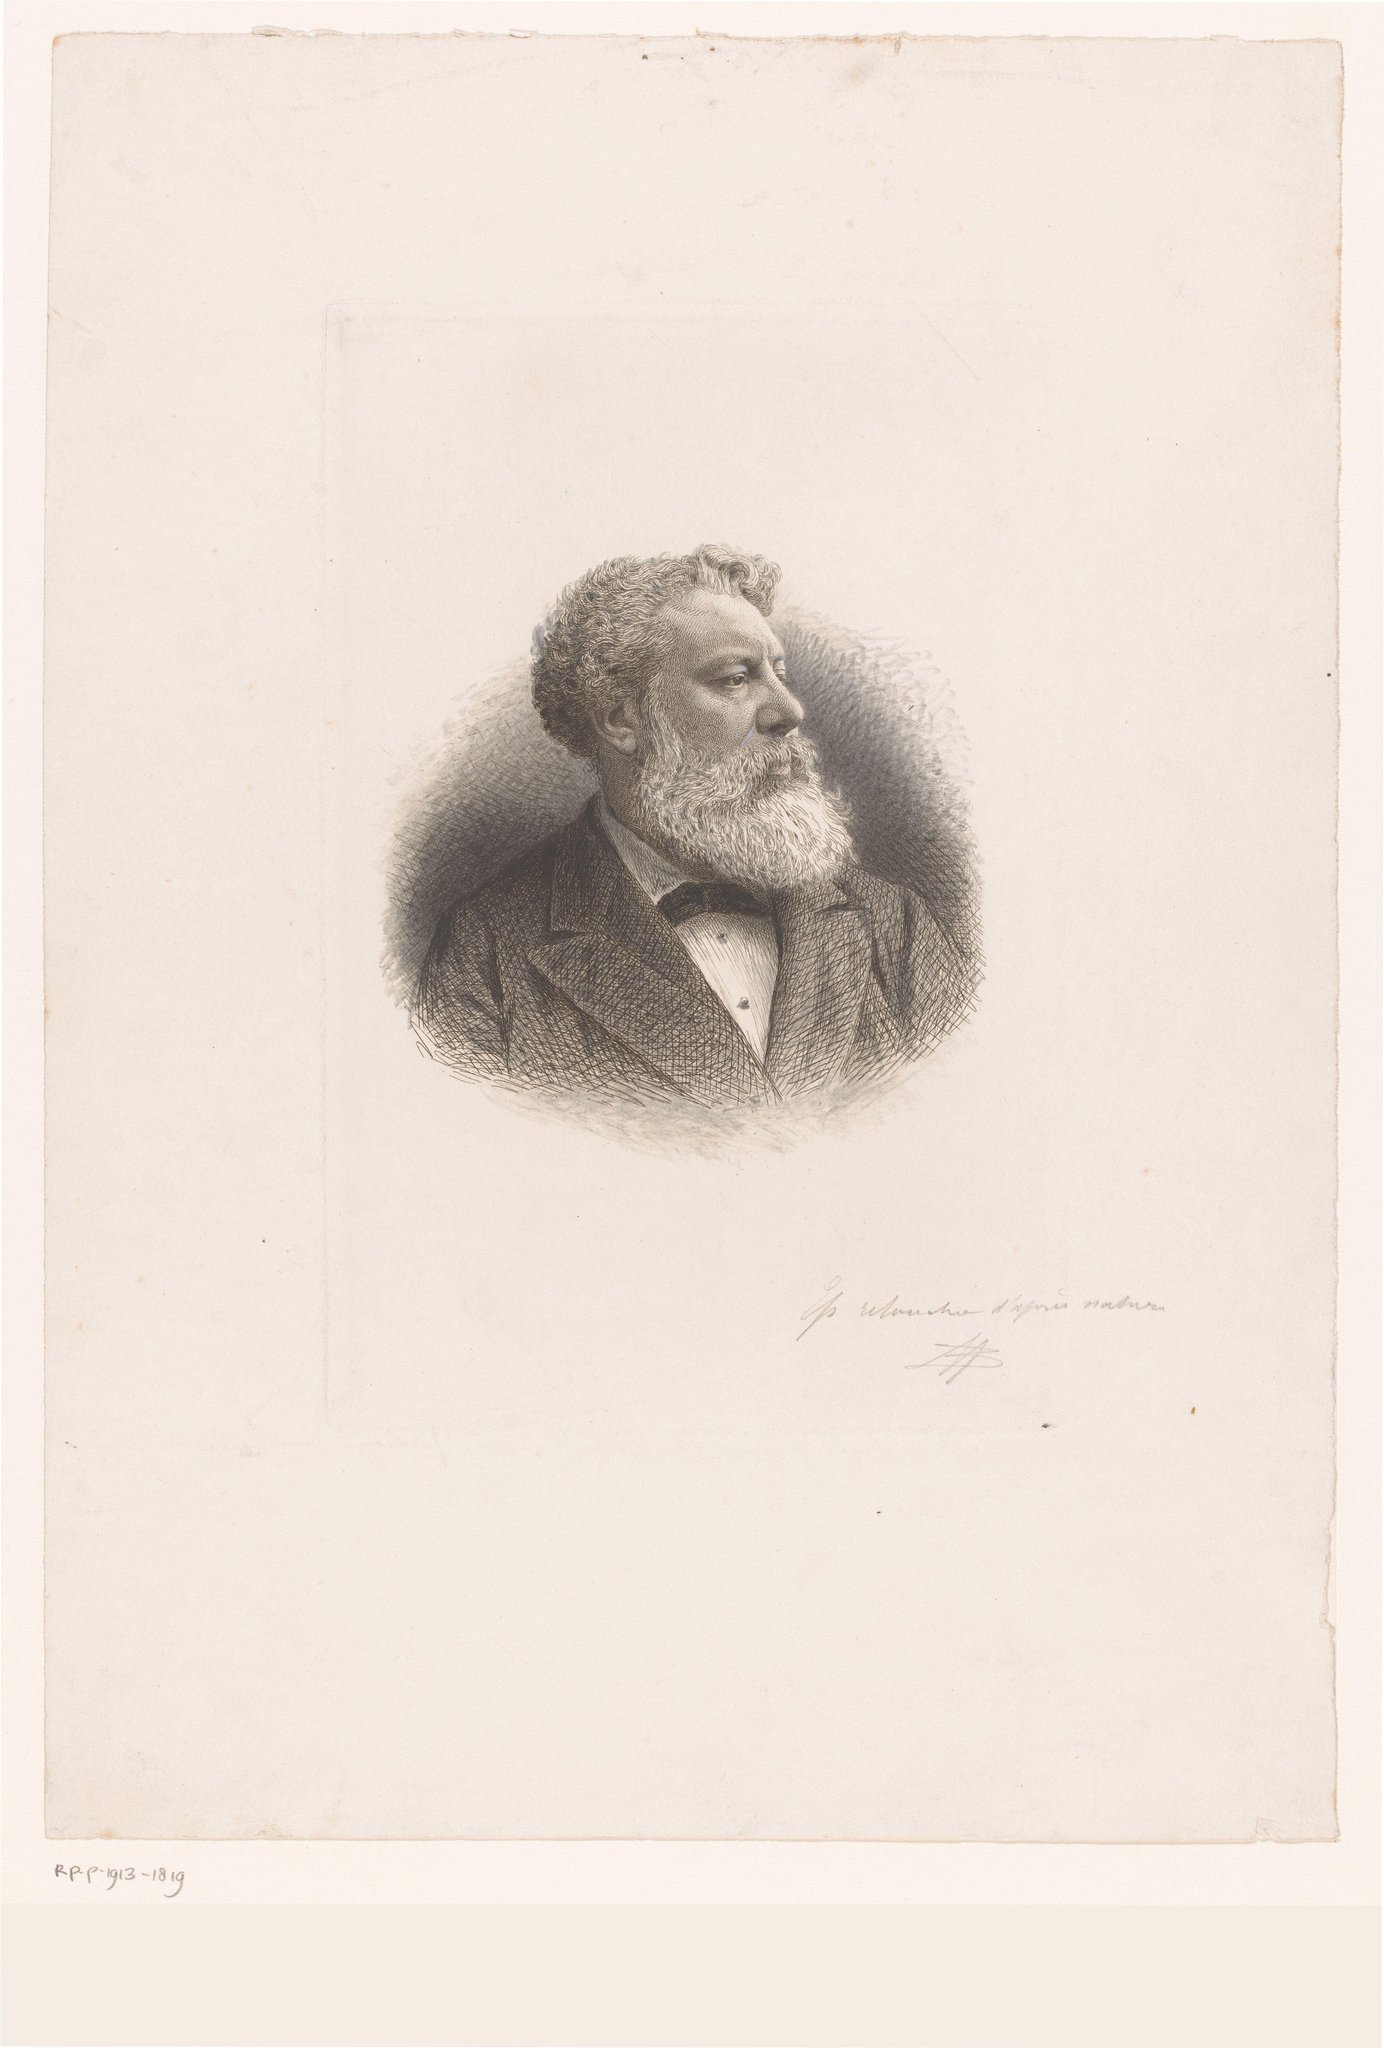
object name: print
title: Portret van Henri François Schaefels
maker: jean baptiste pierre michiels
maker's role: print maker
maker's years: 1821-1890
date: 1880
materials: ink, paper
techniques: etching, pen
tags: print maker, henri françois schaefels, adult man, historical persons, beard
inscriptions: inscription: ‘Ep. retouchée d'apres nature’, collector's mark: Lugt 2228